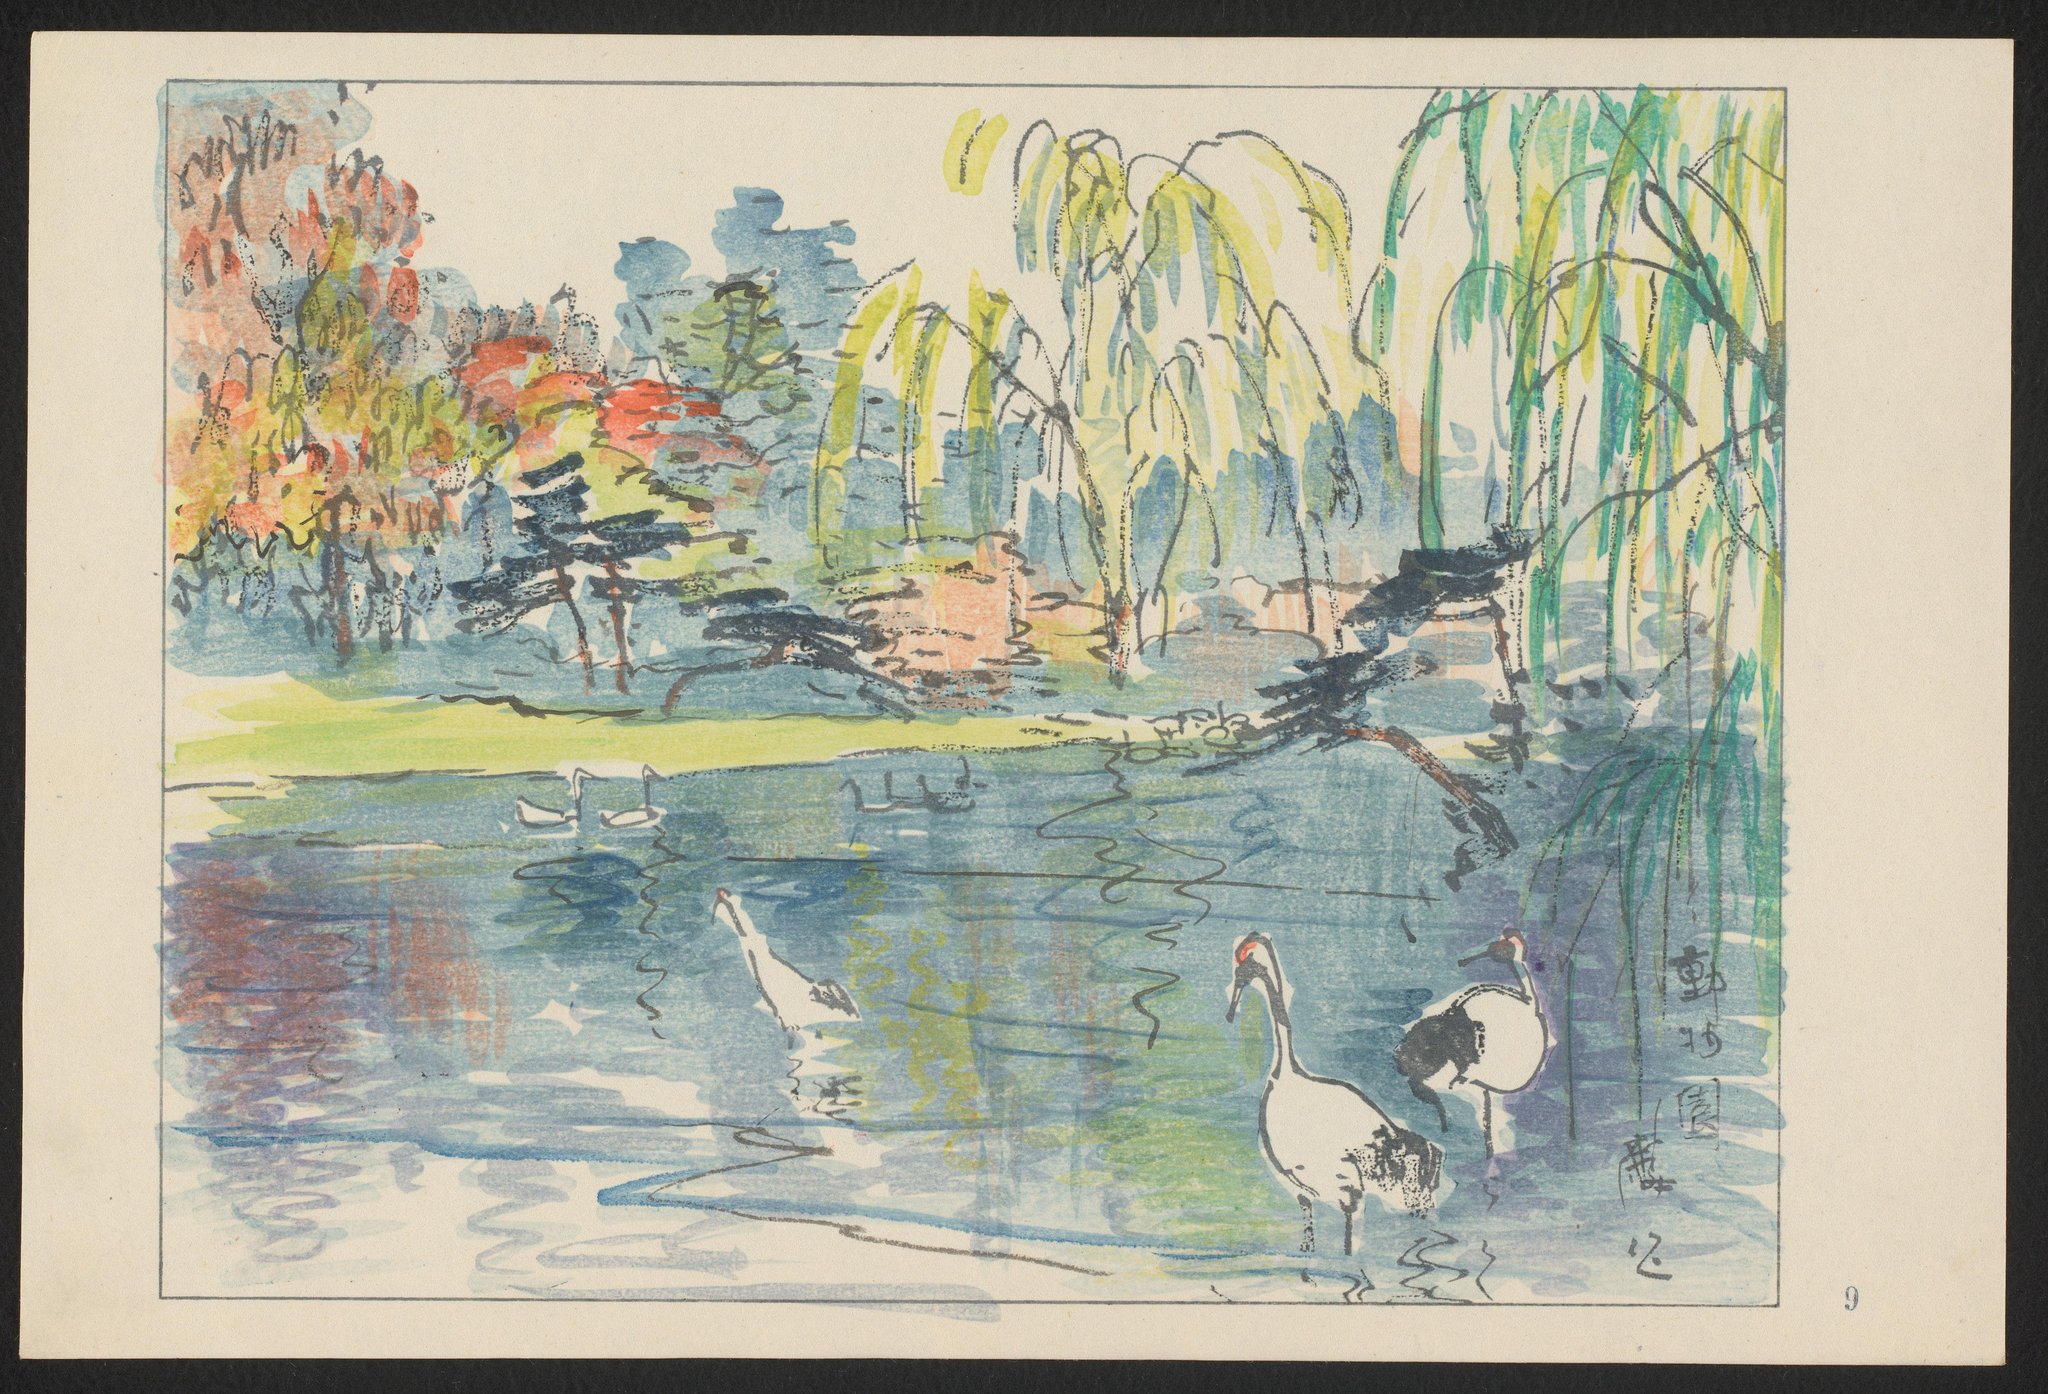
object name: print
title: Zoo at Tennoji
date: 1947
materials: paper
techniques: woodcut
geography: japan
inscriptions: date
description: De vijver met reigers in de dierentuin van Tennôji.